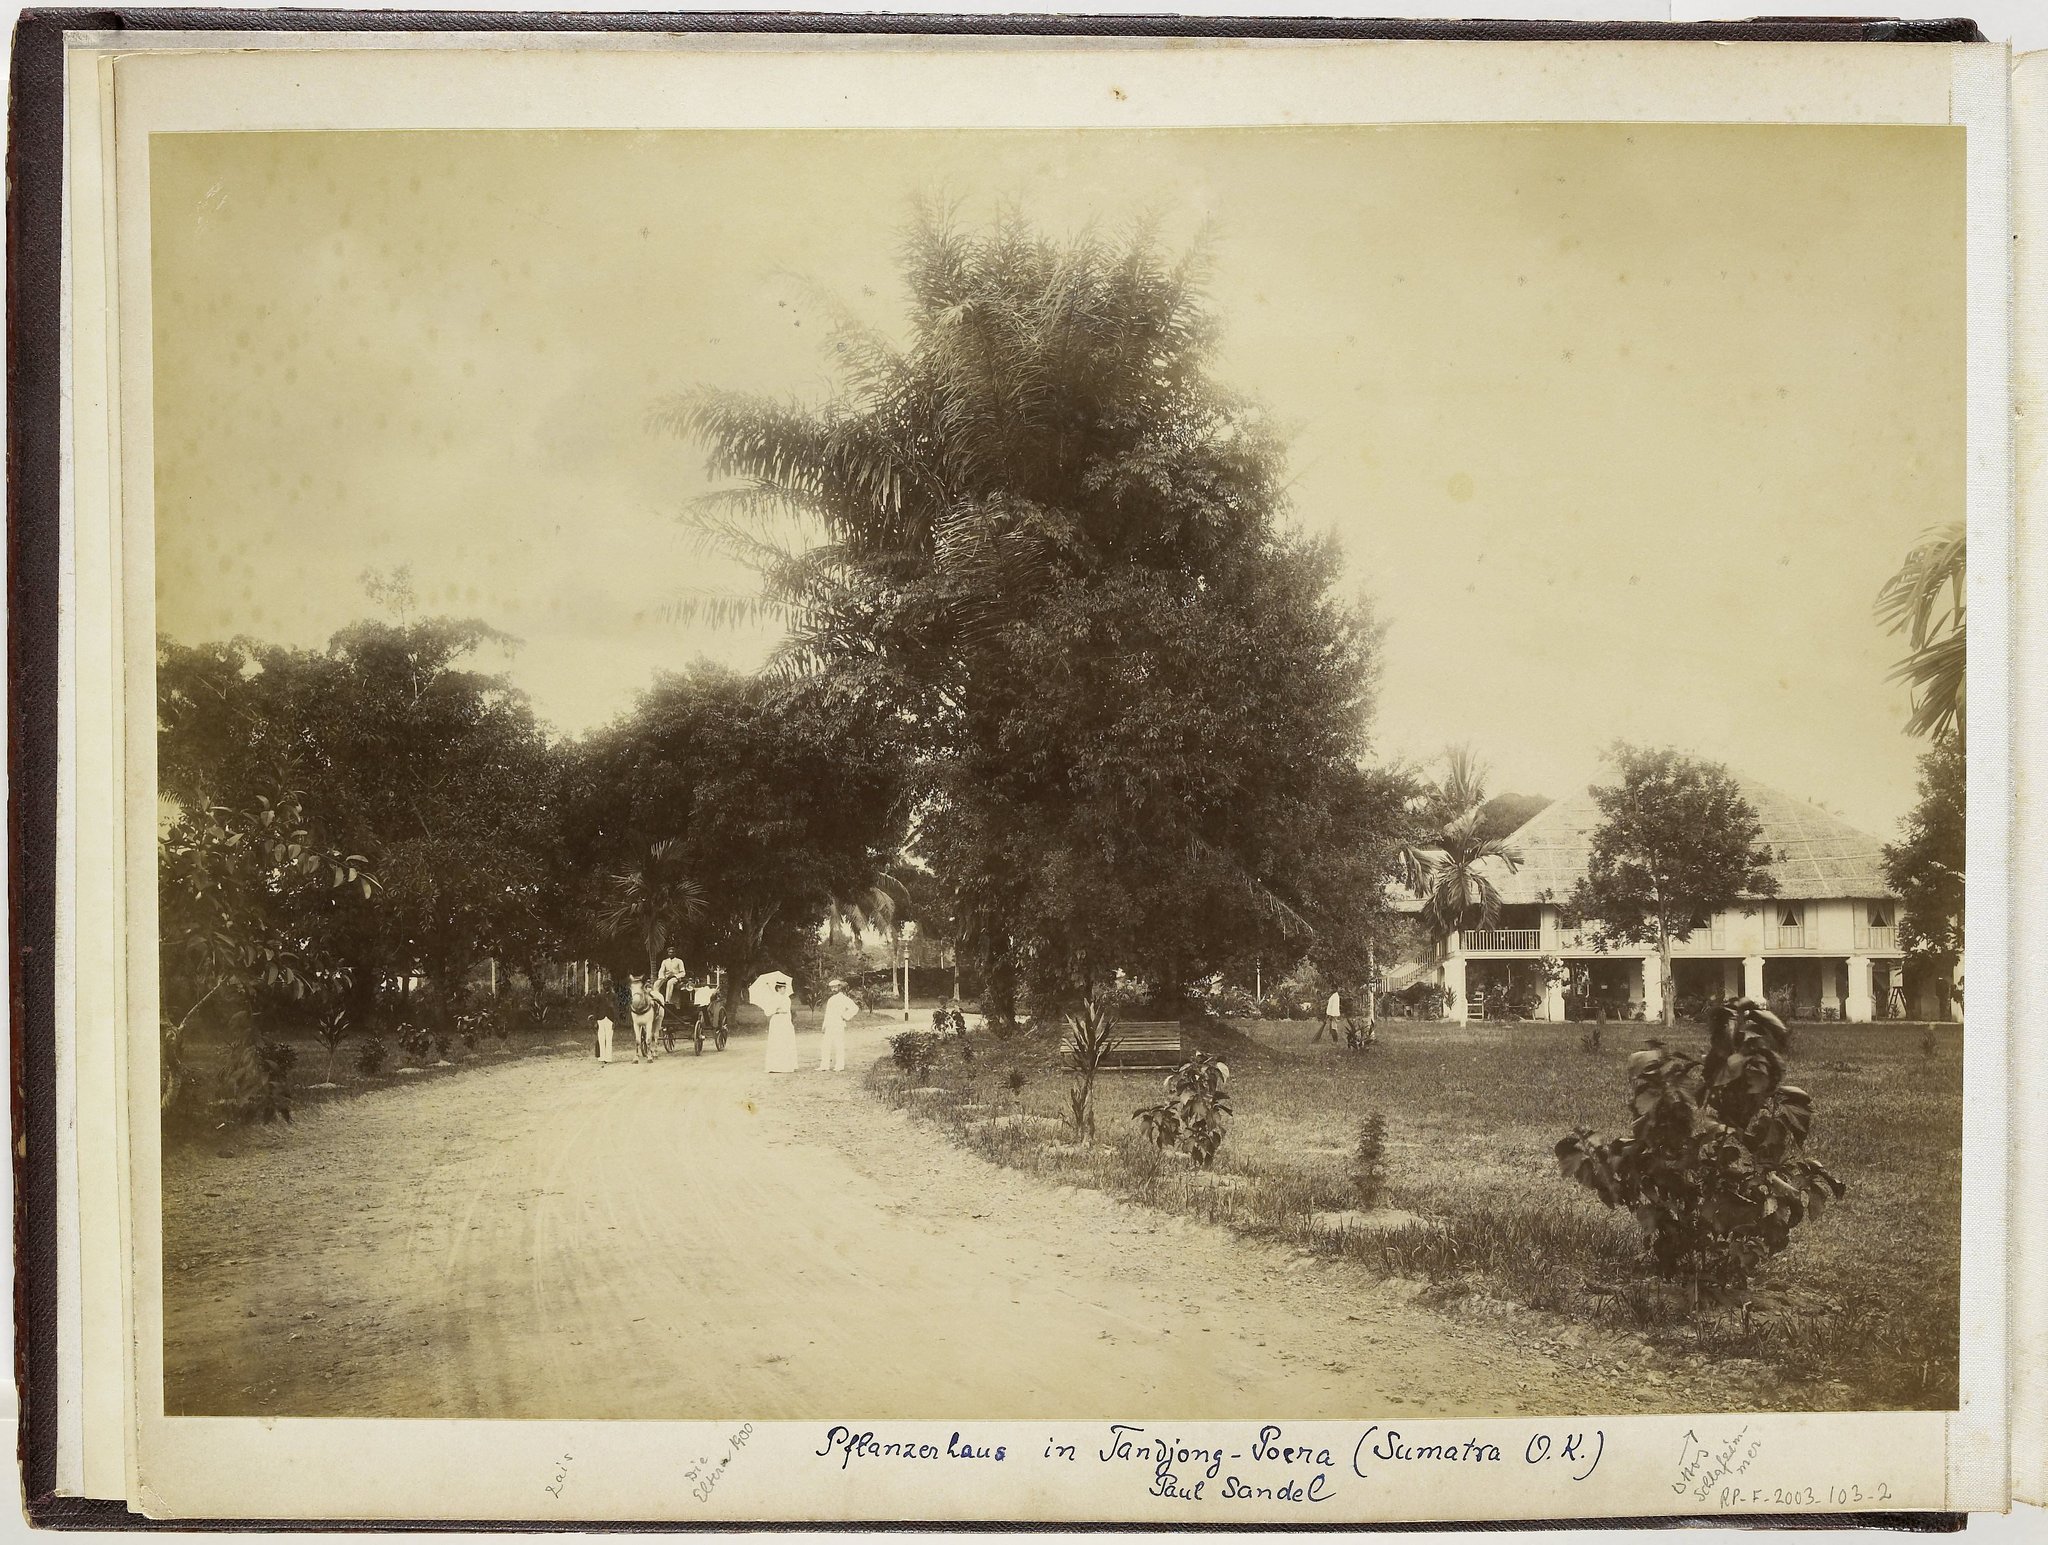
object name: photograph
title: Het huis van Paul Sandel in Tandjong Poera, Langkat Sumatra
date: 1900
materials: cardboard, paper, photographic support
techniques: albumen print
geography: bindjai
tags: sumatra